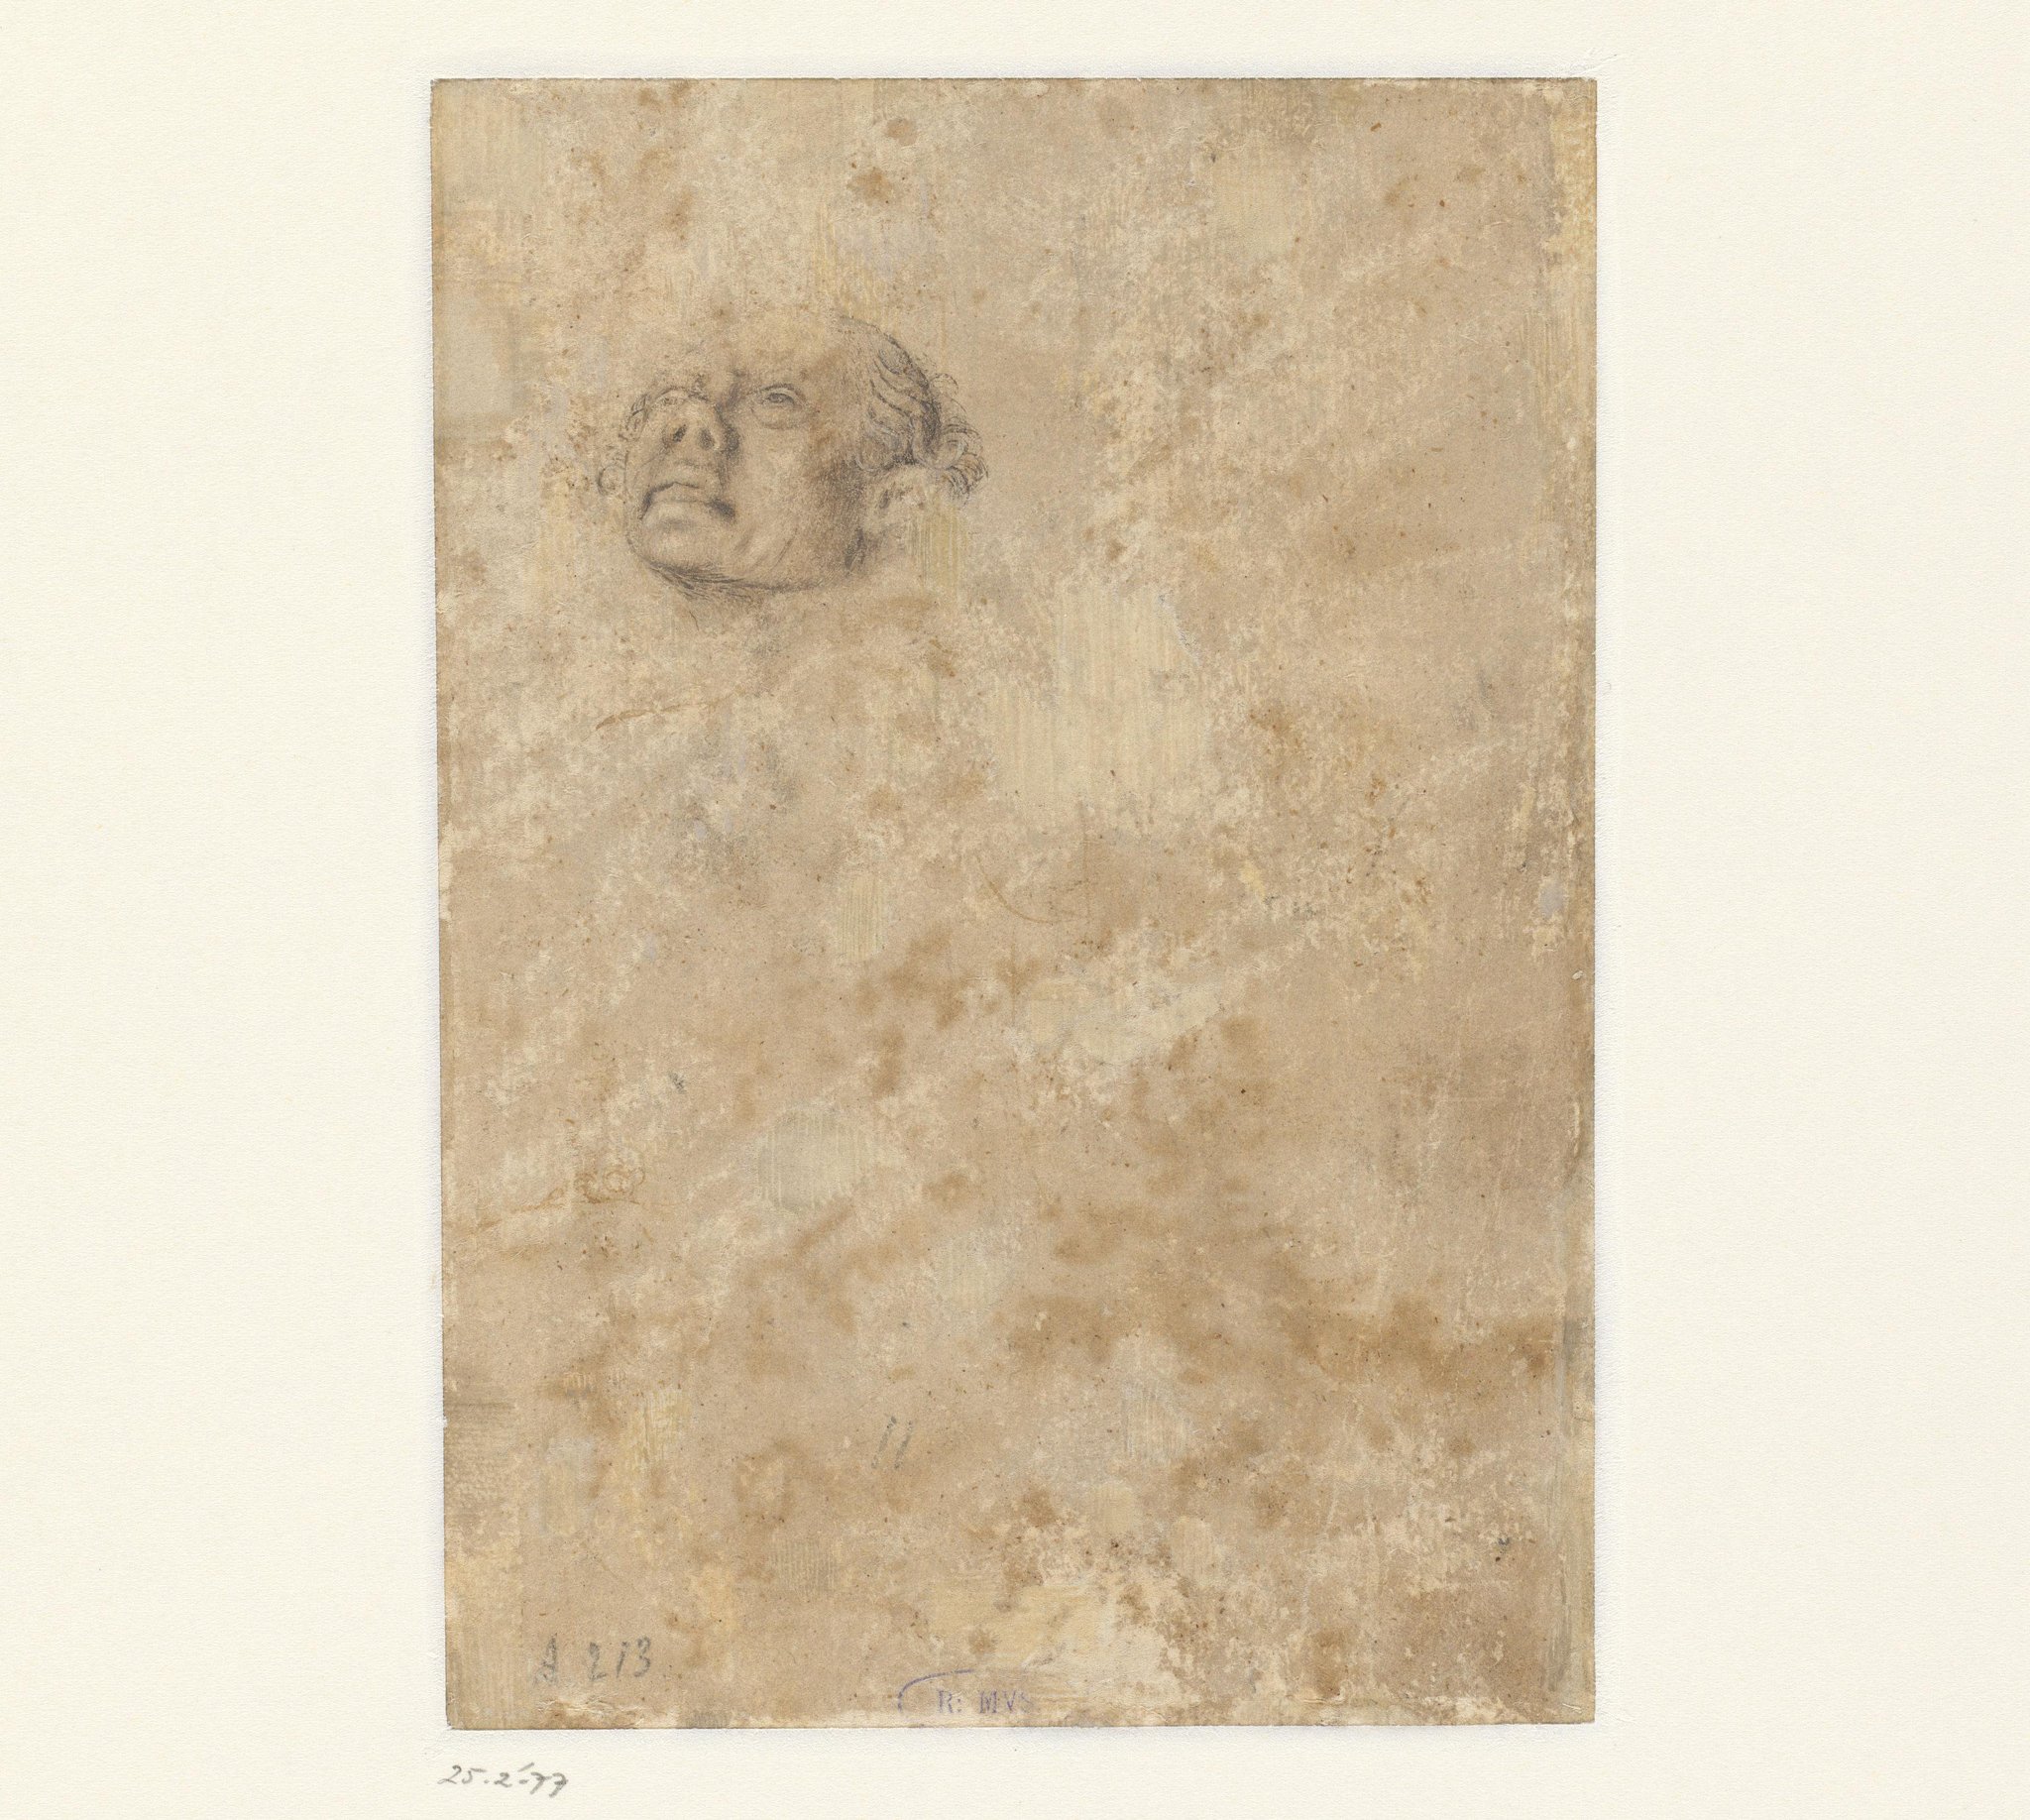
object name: drawing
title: Hoofd van één van de dieven van een kruisiging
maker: Anonymous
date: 1425-1440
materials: ink, paint, paper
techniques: brush, pen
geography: southern netherlands